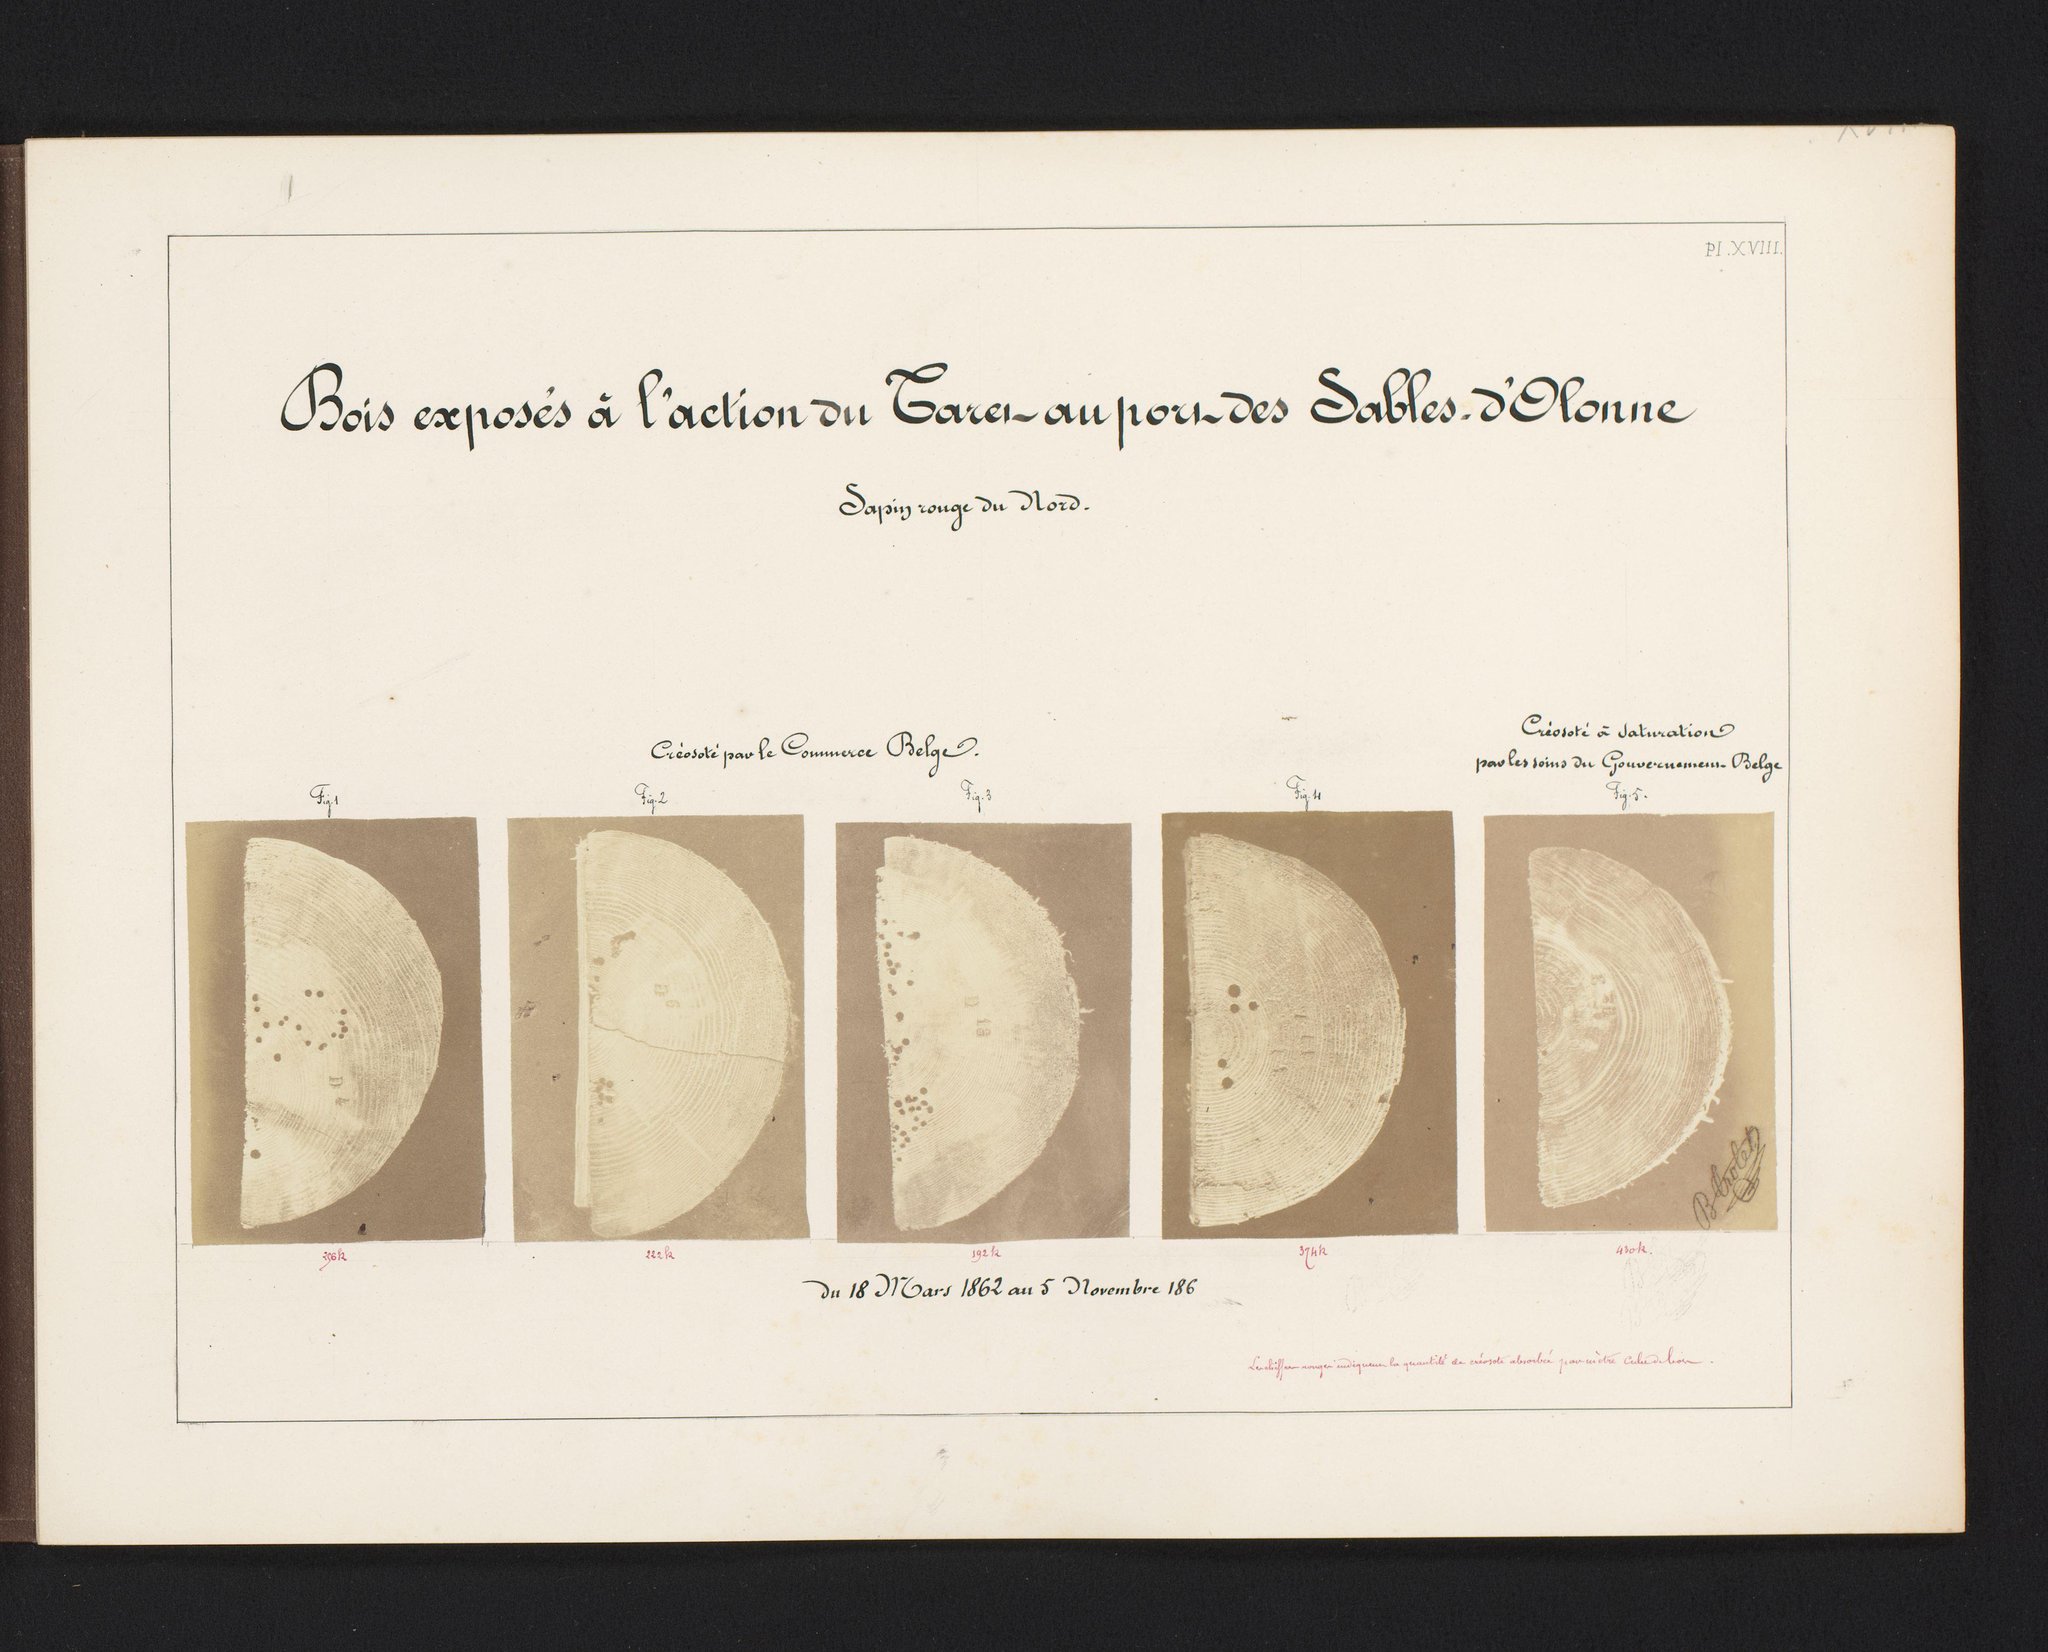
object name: photograph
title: Bois exposés à l'action du Taret au port des Sables-d'Olonne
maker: b. crolet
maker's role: fotograaf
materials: cardboard, photographic support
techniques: albumen print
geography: france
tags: worms, wood, timber ~ building material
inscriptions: number: ‘Pl. XVIII.’, annotation: ‘Sapin rouge du Nord/ (...)/ mètre Cube de bois.’, signature: ‘B. Crolet’